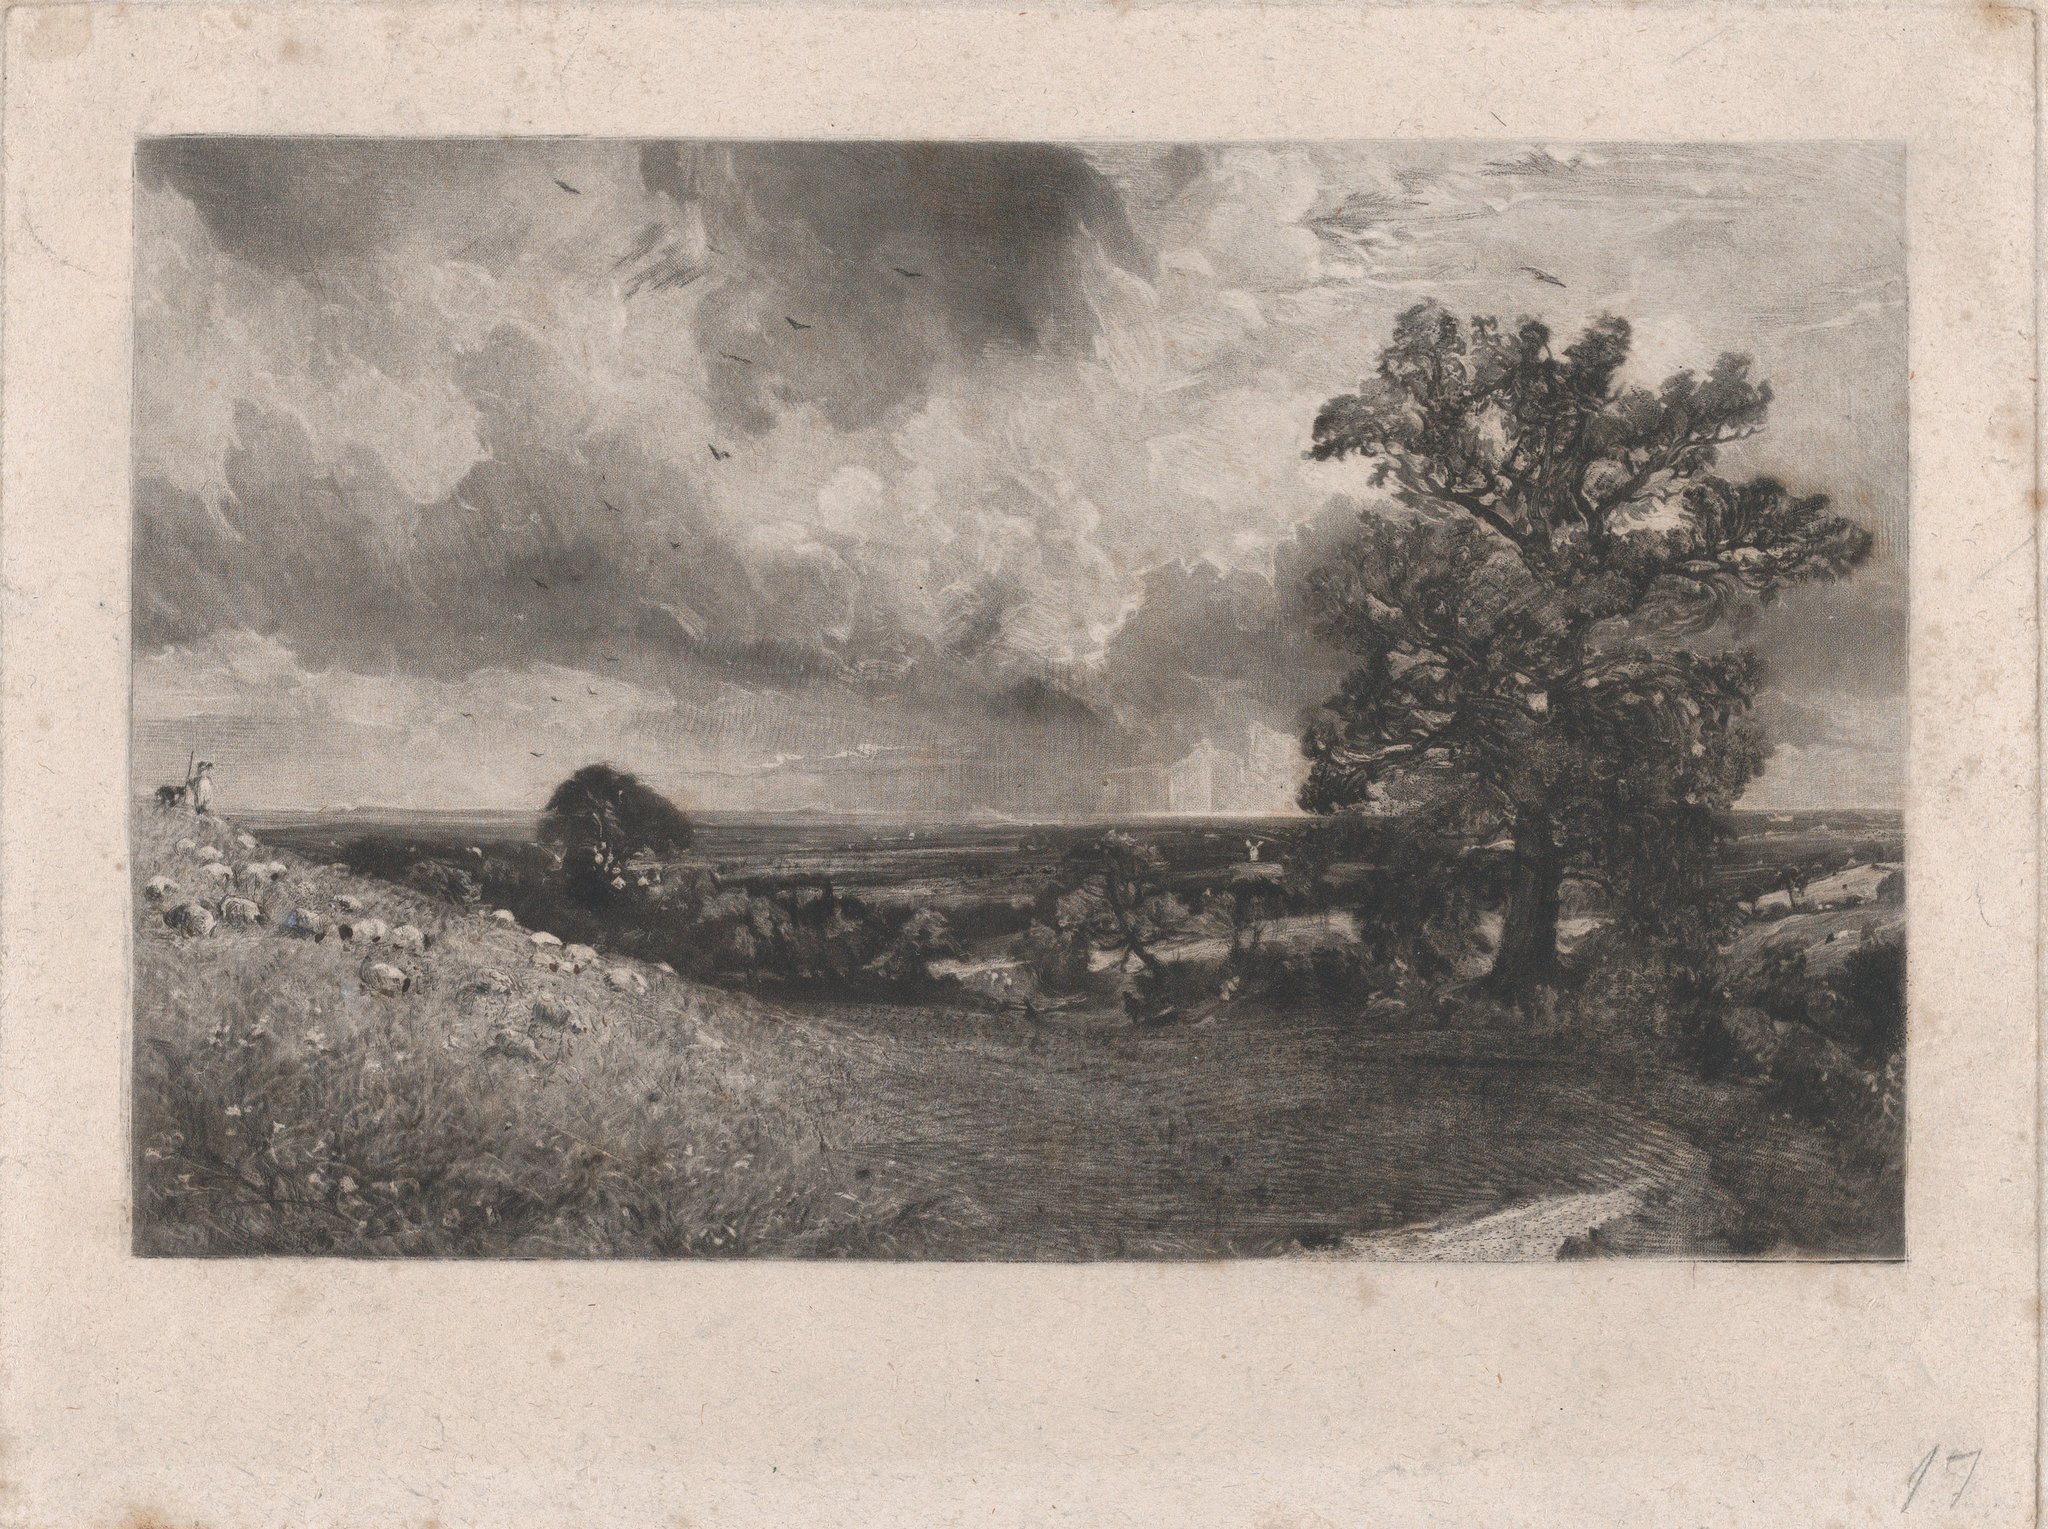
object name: print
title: Noon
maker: david lucas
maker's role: artist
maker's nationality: british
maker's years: 1802-1881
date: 1830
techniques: mezzotint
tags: landscapes